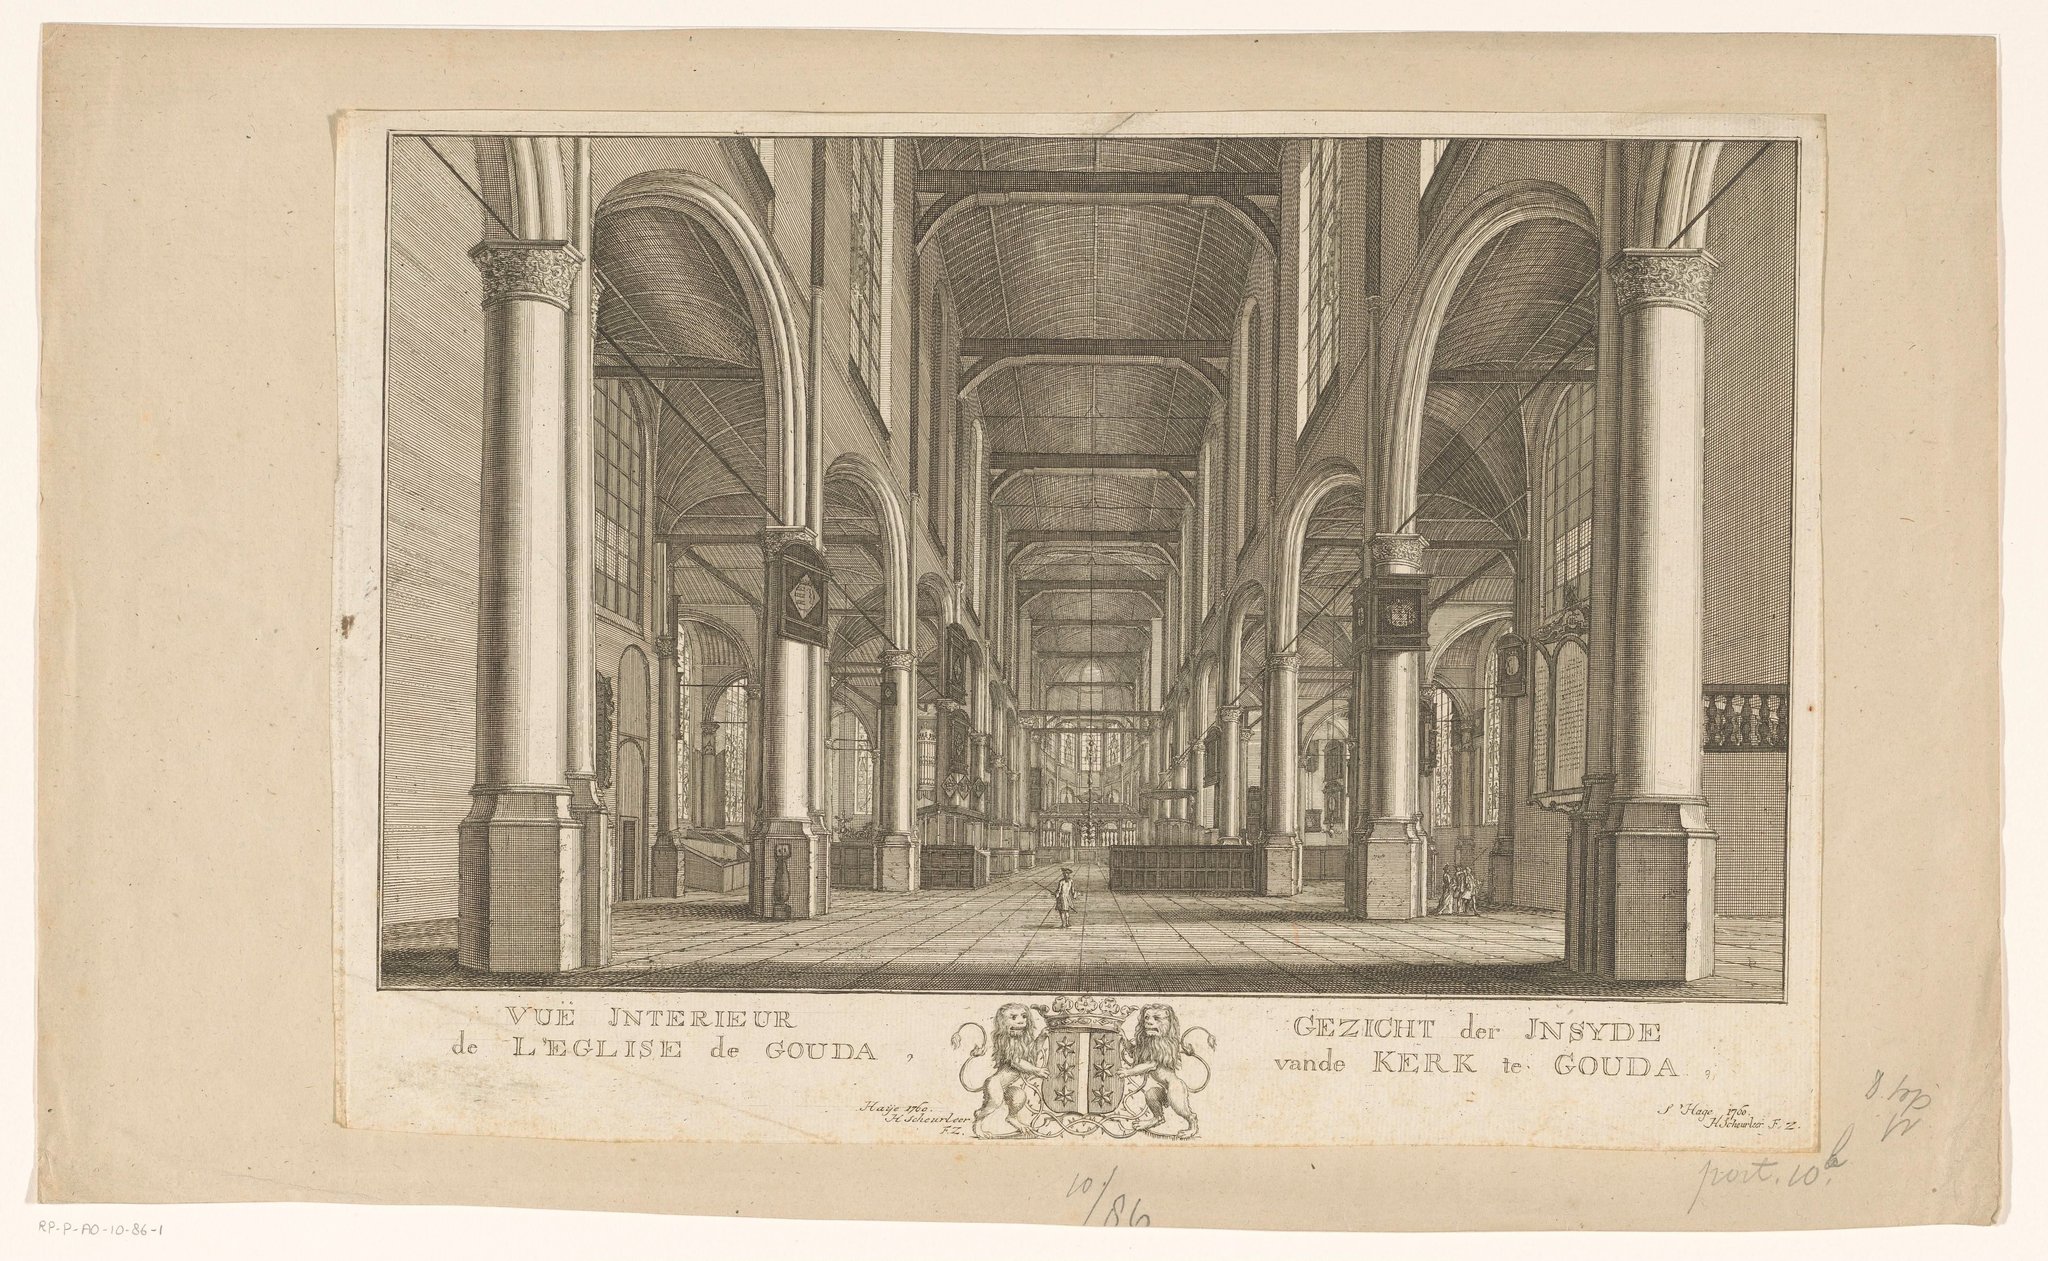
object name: print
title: Gezicht der insyde vande kerk te Gouda / Vuë interieur de l'eglise de Gouda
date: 1760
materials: paper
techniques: engraving, etching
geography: the hague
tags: interior of church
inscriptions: date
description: Het interieur van de Sint-Janskerk te Gouda. In de kerk staan enkele figuren.